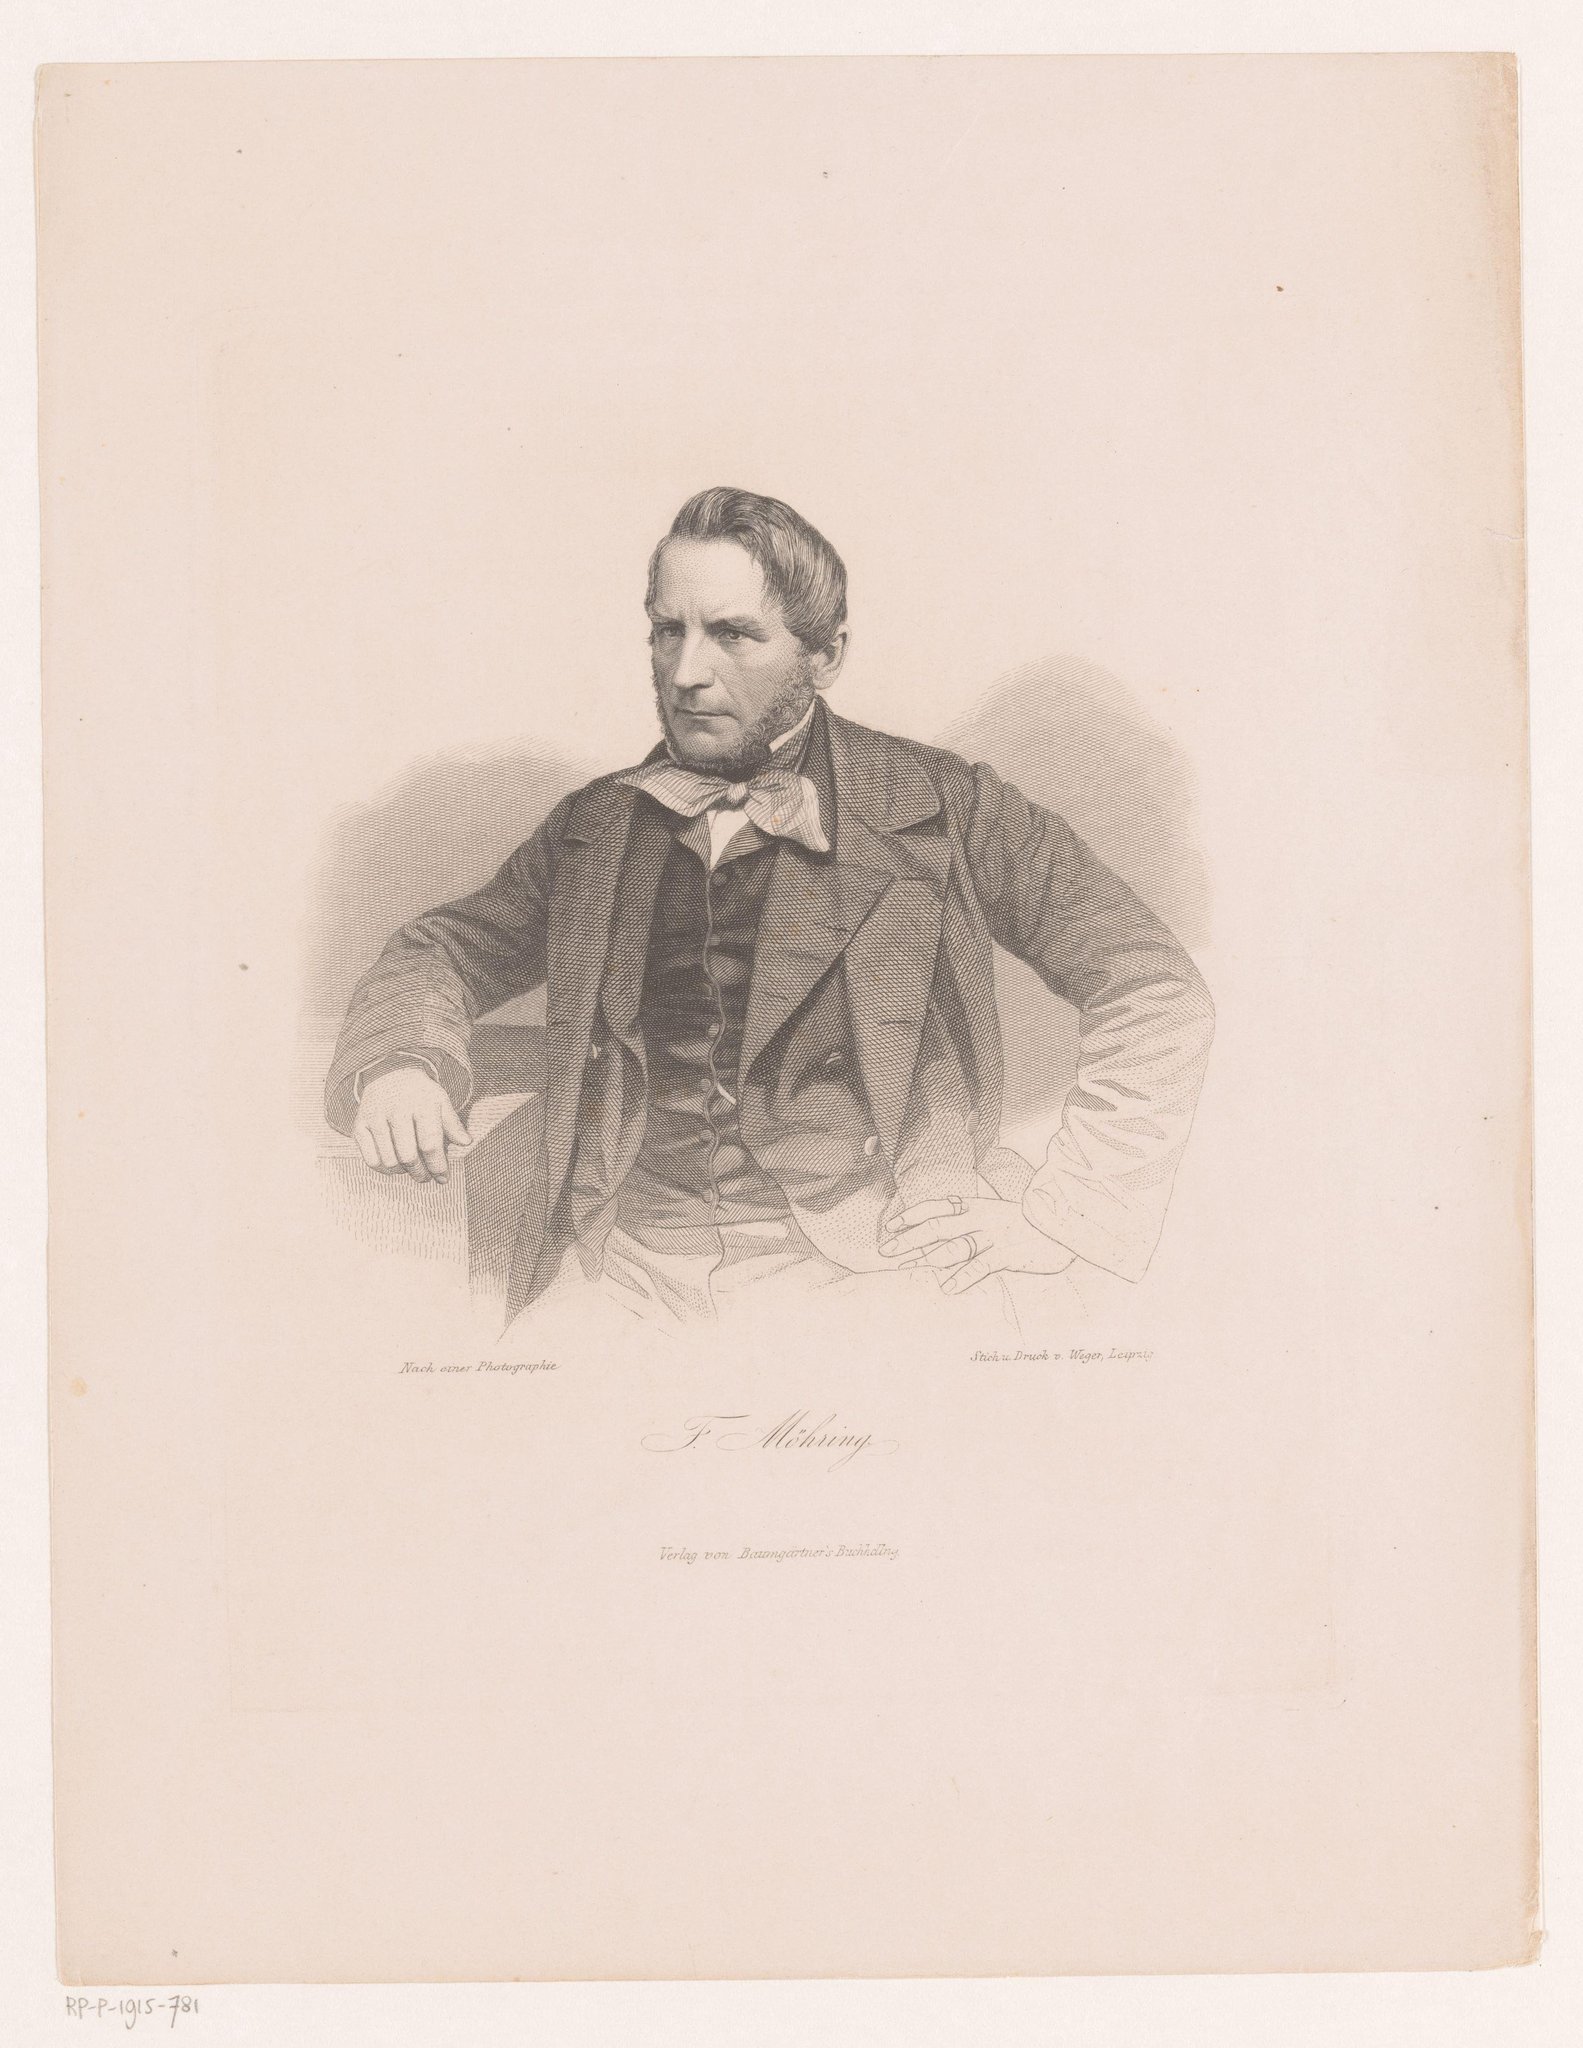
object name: print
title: Portret van Ferdinand Möhring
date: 1849-1892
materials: paper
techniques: engraving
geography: leipzig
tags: historical persons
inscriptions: collector's mark: Lugt 2228